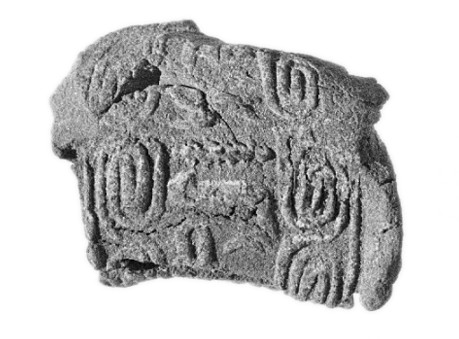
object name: sealing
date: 1981-1640 BCE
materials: mud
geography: egypt